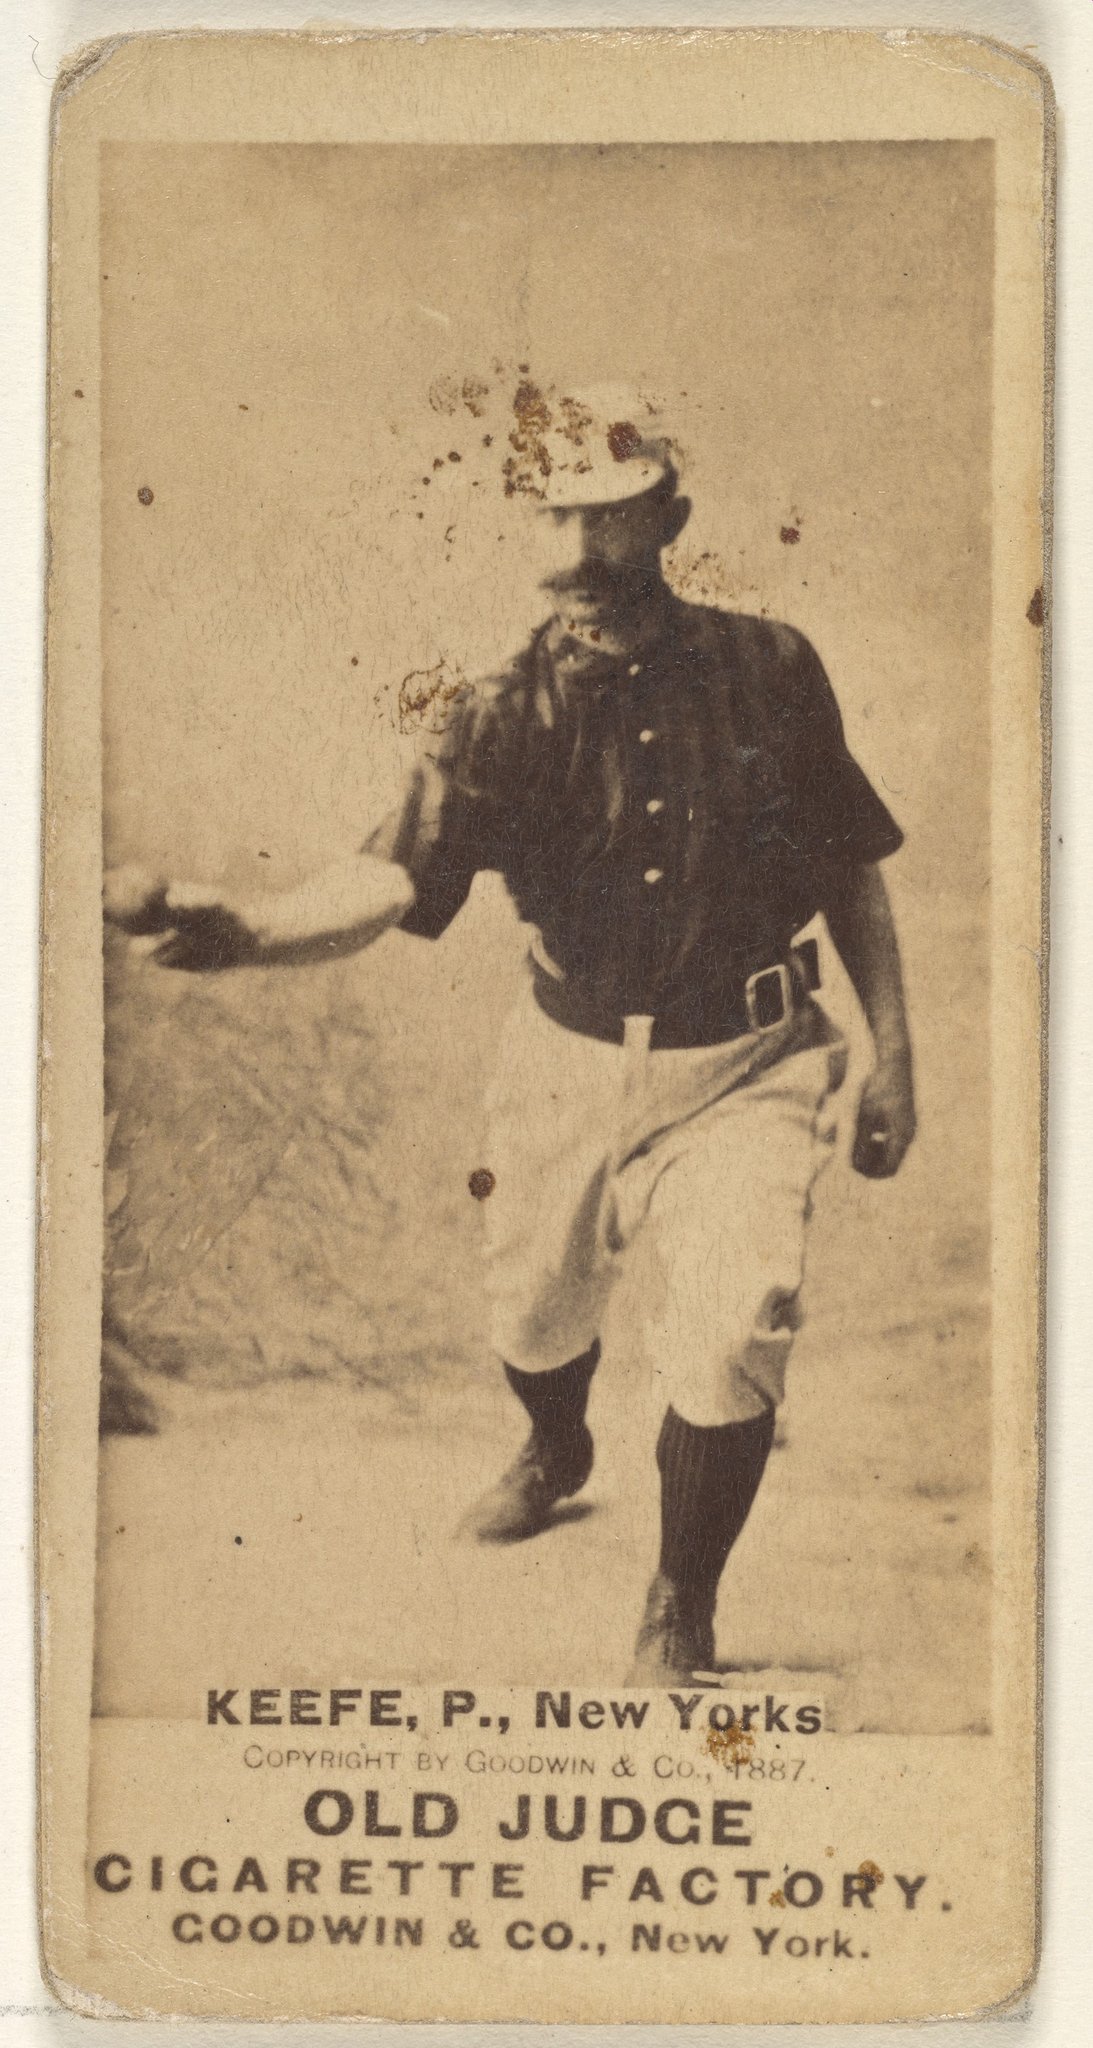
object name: baseball card, photograph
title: Timothy John "Tim" Keefe, Pitcher, New York, from the Old Judge series (N172) for Old Judge Cigarettes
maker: goodwin & company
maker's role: publisher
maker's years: 1850-1950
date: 1887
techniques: albumen silver print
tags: men,portraits,baseball,athletes